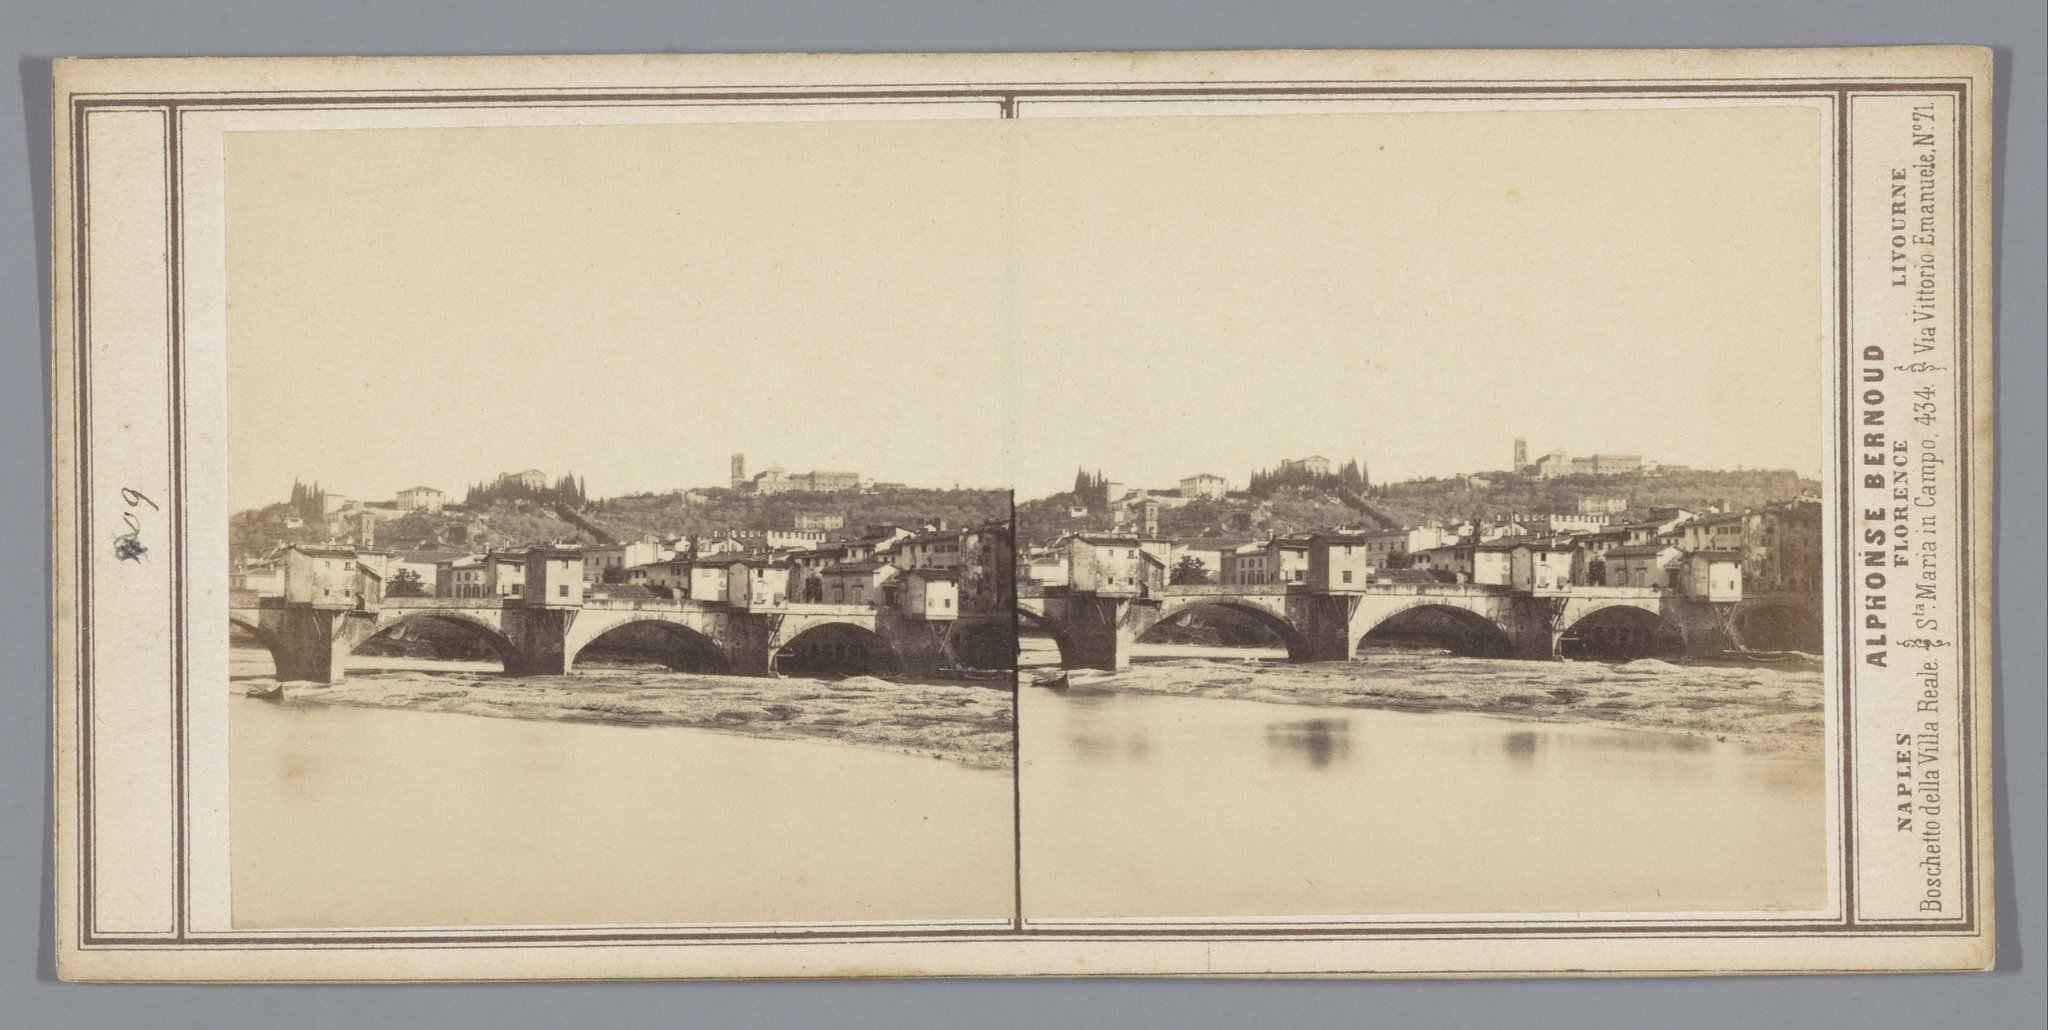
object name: stereograph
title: Gezicht op de Ponte alle Grazie te Florence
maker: alphonse bernoud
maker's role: fotograaf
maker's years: 1820-1889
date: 1850-1880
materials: cardboard, photographic support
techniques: albumen print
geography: florence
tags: river, bridge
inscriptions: number: ‘604’, inscription: ‘Ponte alle Grazie’, name: ‘ALPHONSE BERNOUD NAPLES Boschetto della Villa Reale. FLORENCE Sta. Maria in Campo, 434. LIVOURNE Via Vittorio Emanuele, No. 71.’